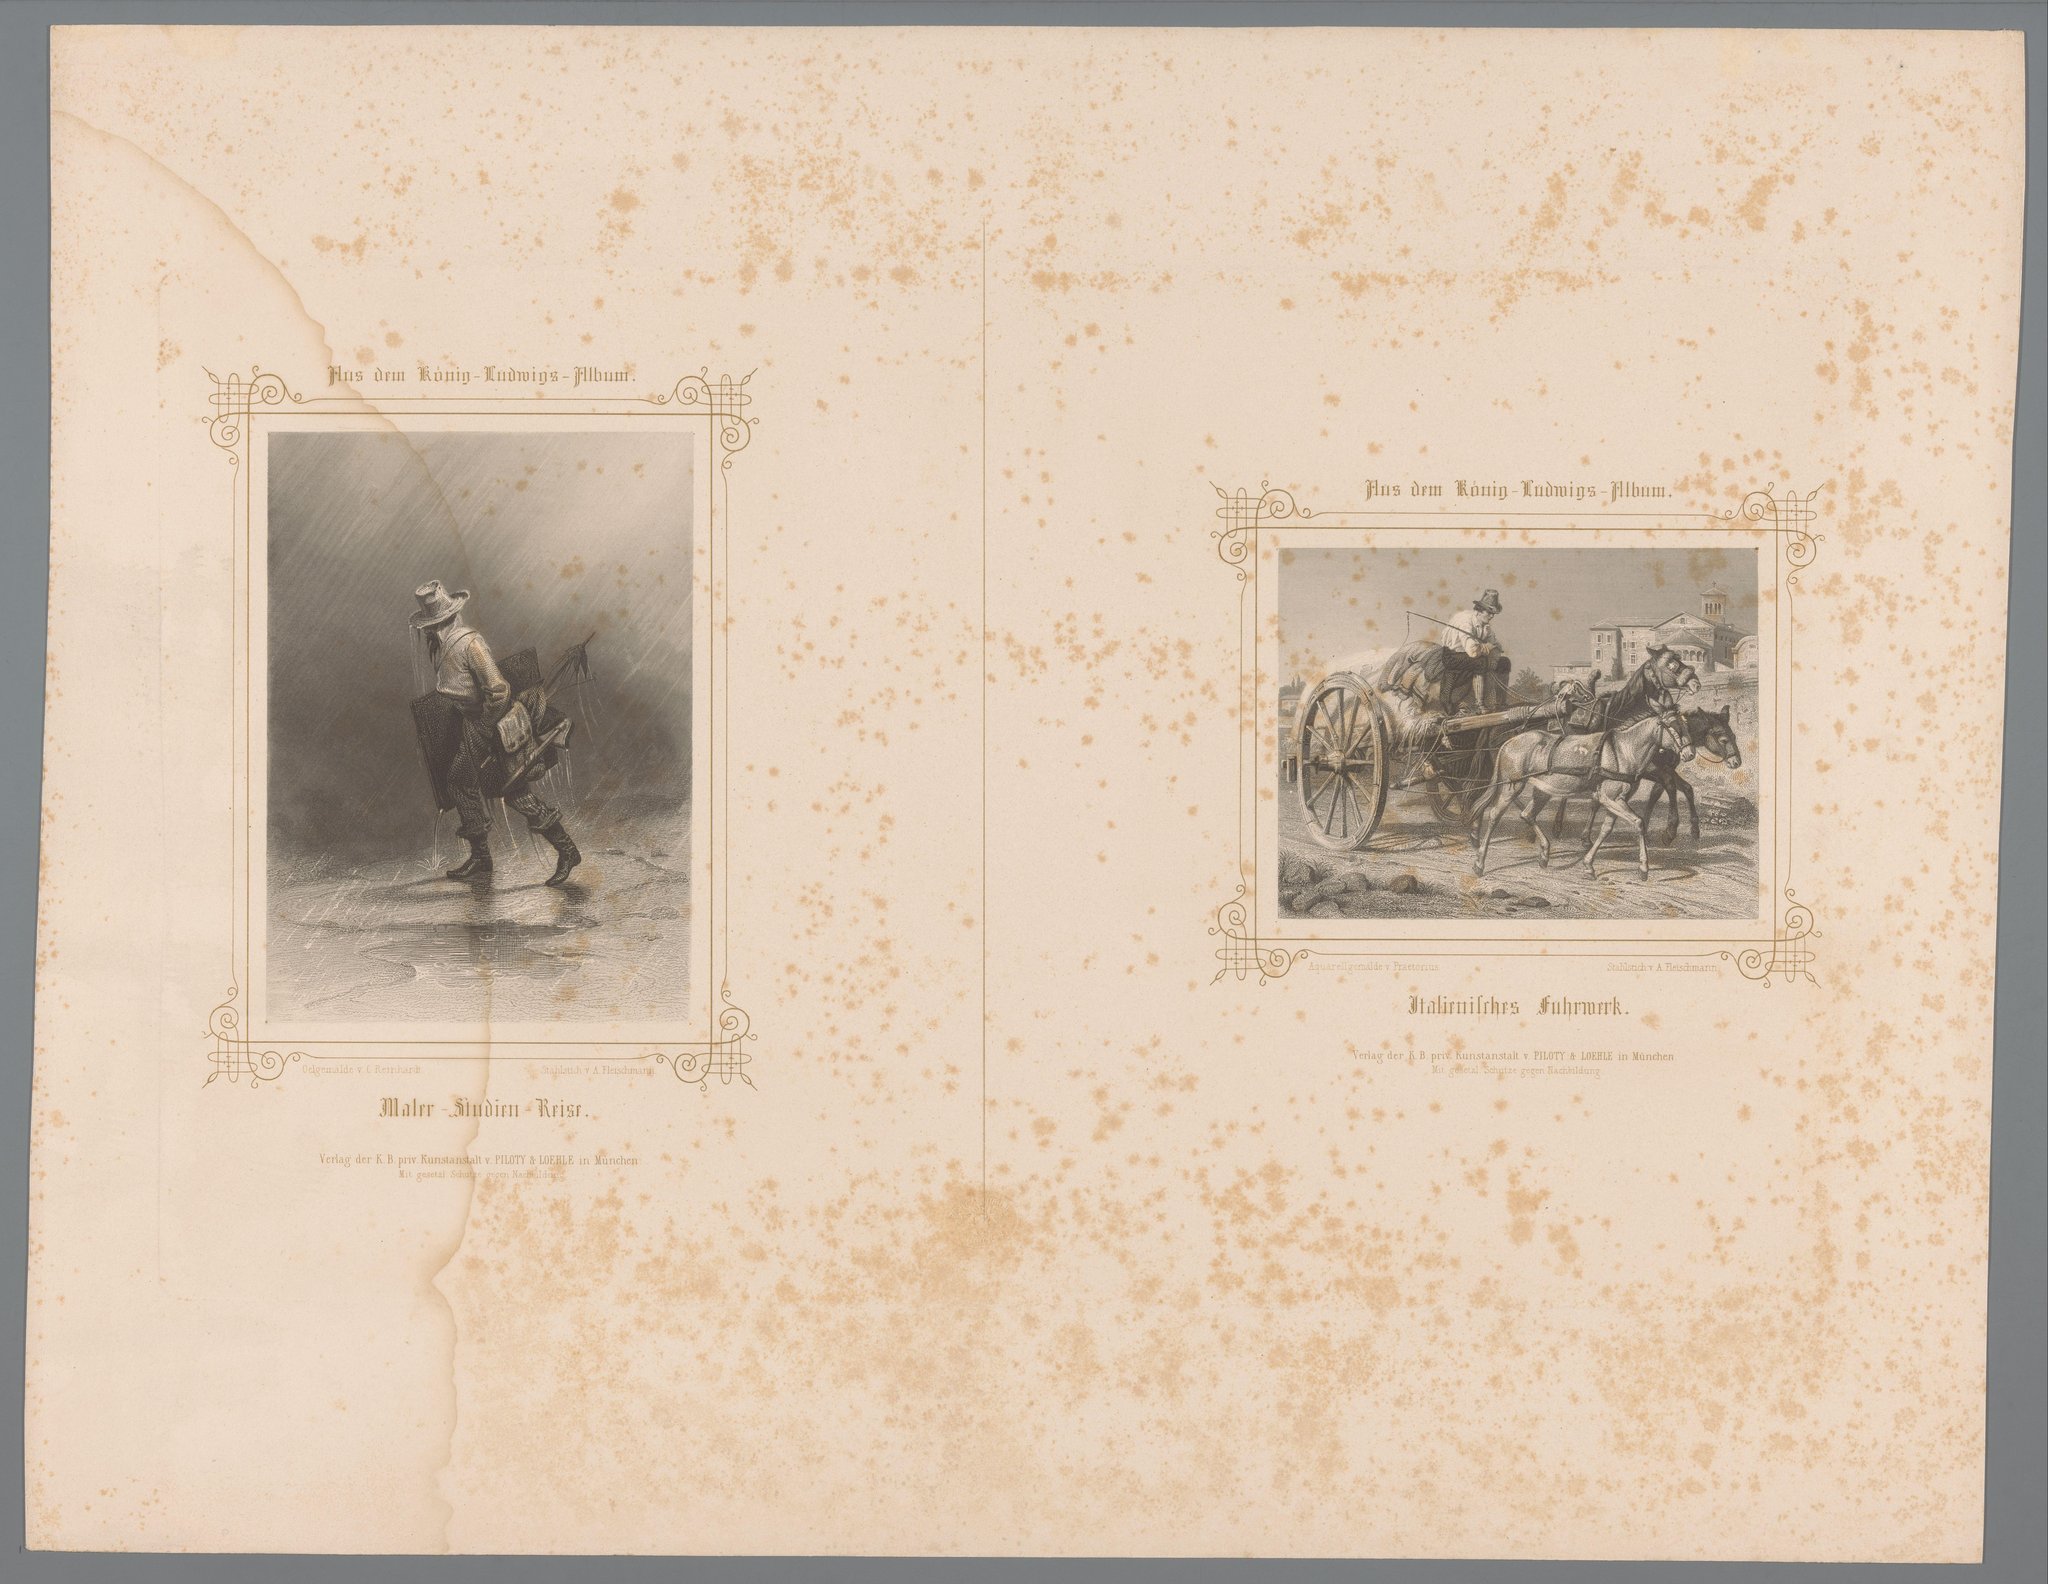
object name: print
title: Twee voorstellingen uit het König-Ludwigs Album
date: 1850-1859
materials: paper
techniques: lithograph, engraving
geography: munich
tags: downpour, rain shower, city-view, and landscape with man-made constructions, horse, painter in non-work situation, hay-wagon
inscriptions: collector's mark: Lugt 2228, address: ‘Piloty & Loehle, München’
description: Prent afkomstig uit de serie 'Album Seiner Majestät des Königs Ludwig I. von Bayern', verschenen in verschillende afleveringen. De prenten gaan terug op het album dat Lodewijk I van Beieren op 9 oktober 1850 kreeg overhandigd van verschillende kunstenaars.